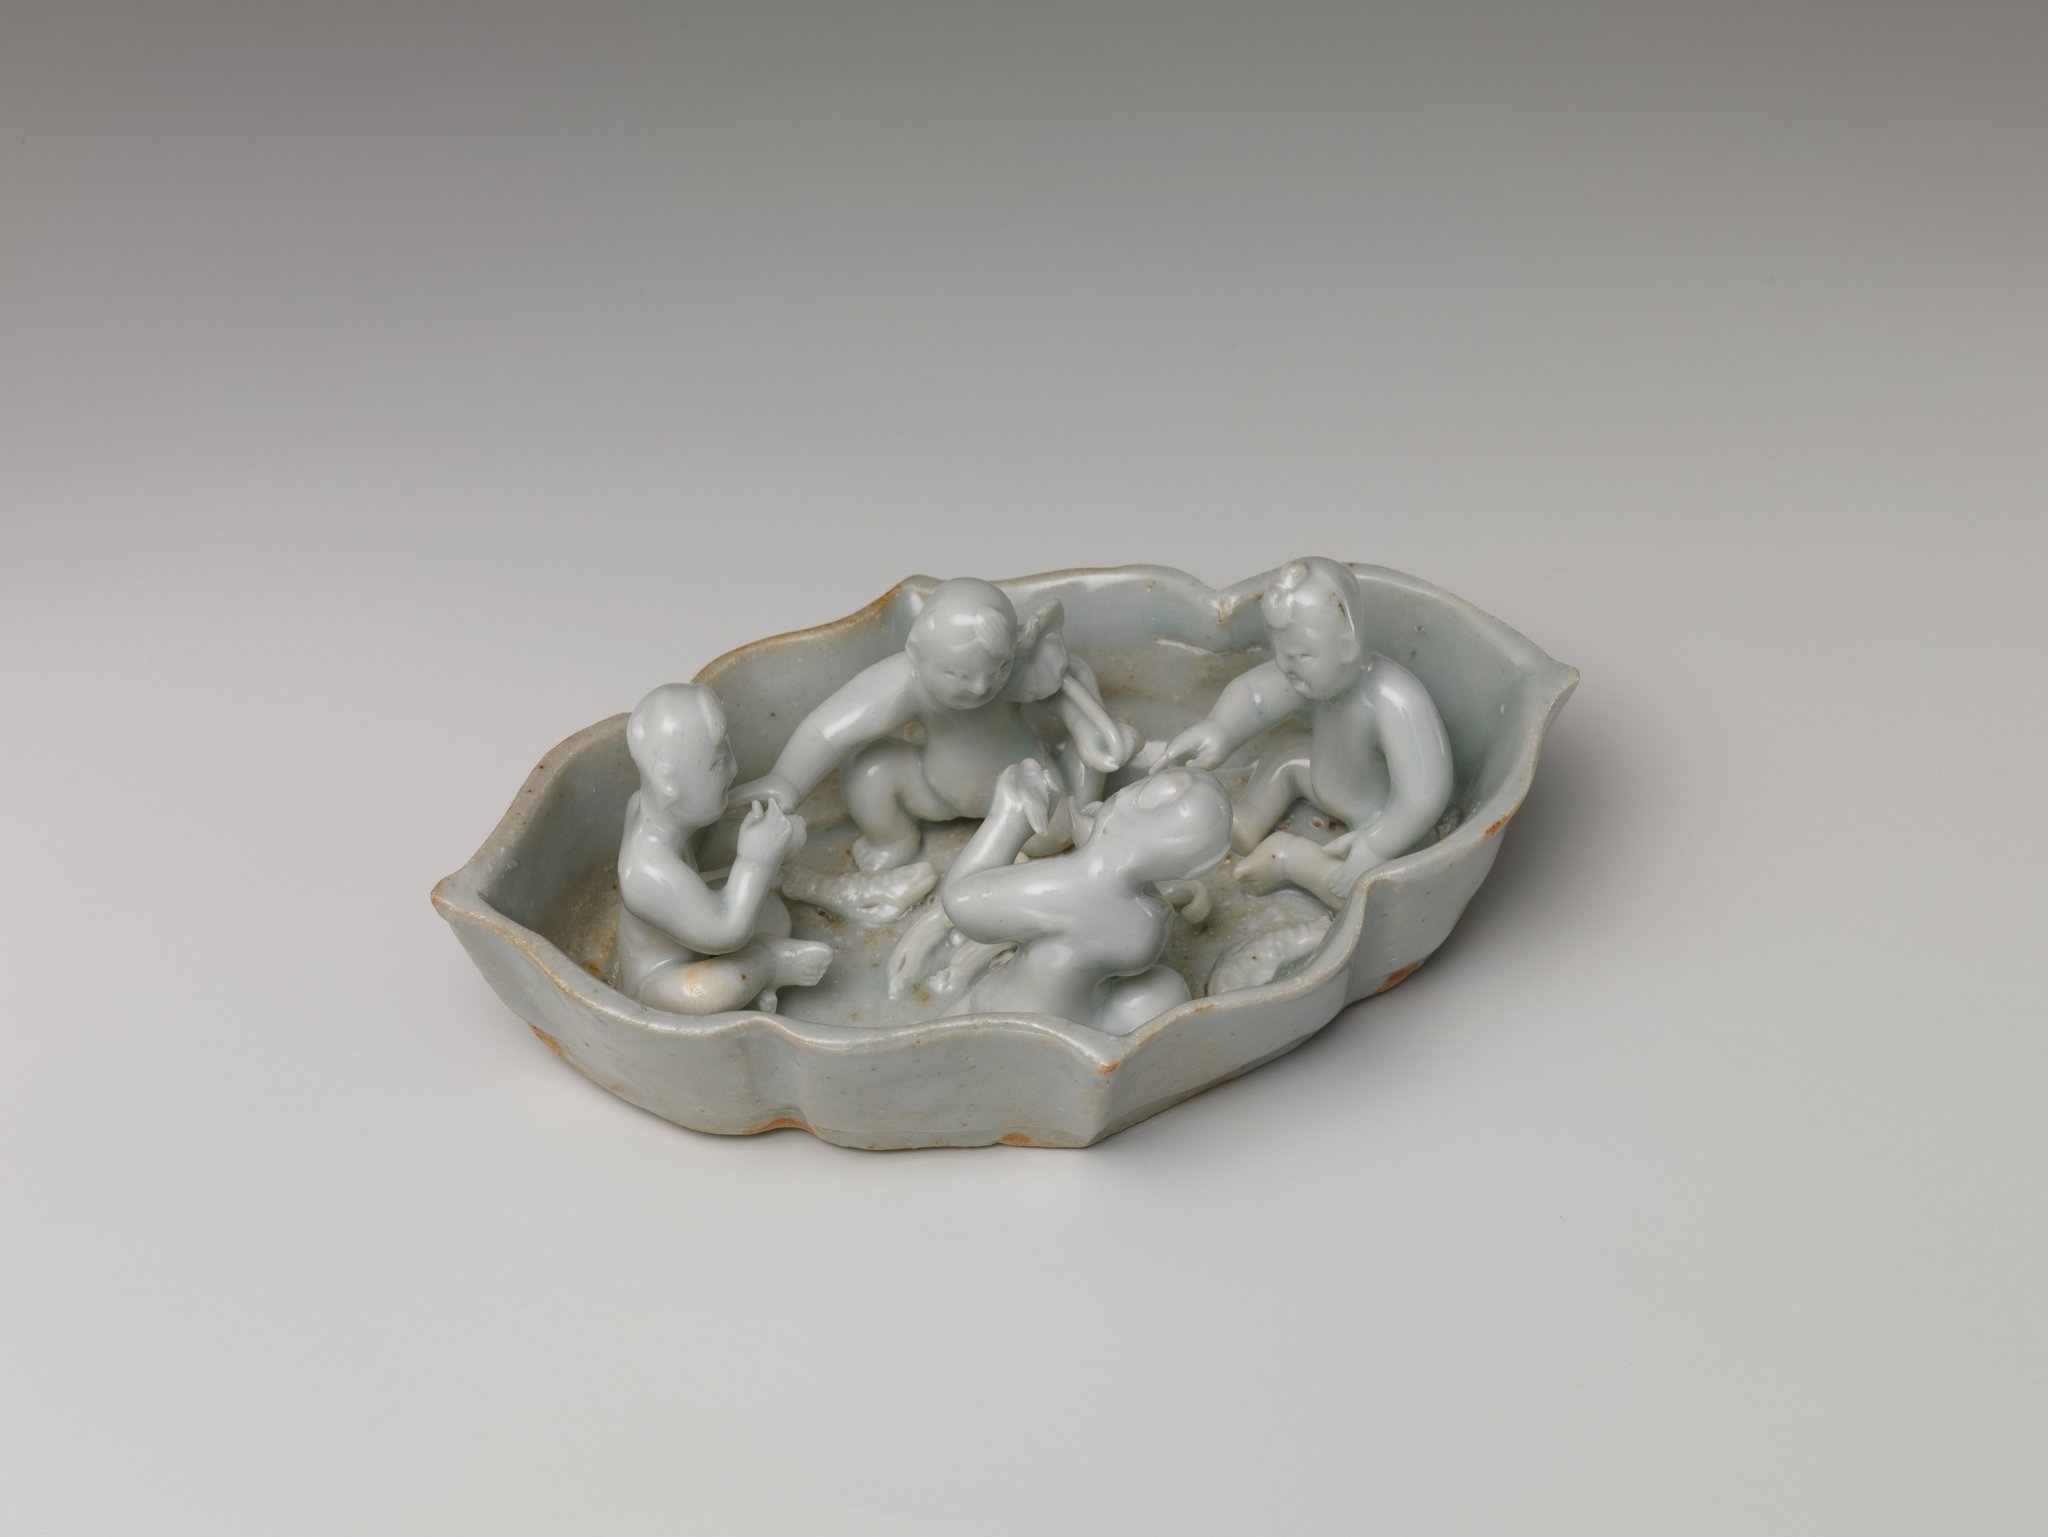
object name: figurine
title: Boys in a lotus pond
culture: chinese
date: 1201-1400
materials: glaze, porcelain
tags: boys,lotuses